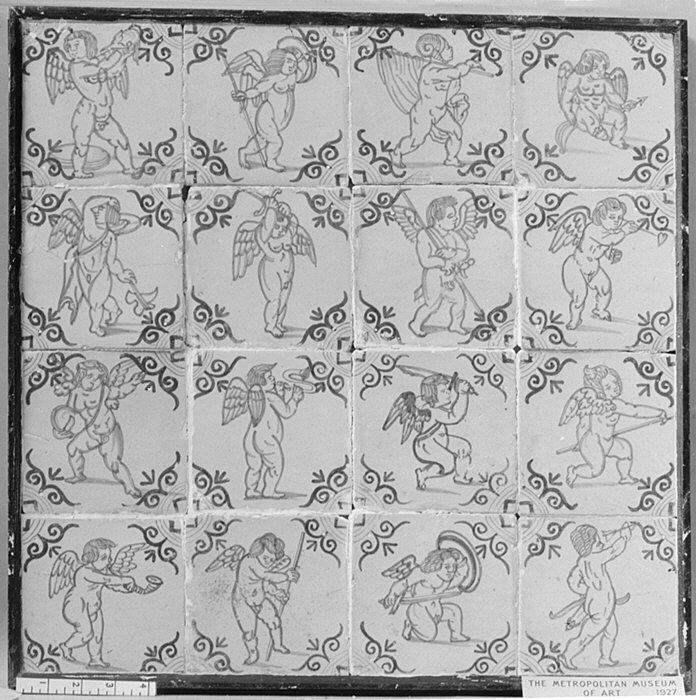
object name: tile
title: Tiles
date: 1667-1700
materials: earthenware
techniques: glazing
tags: putti